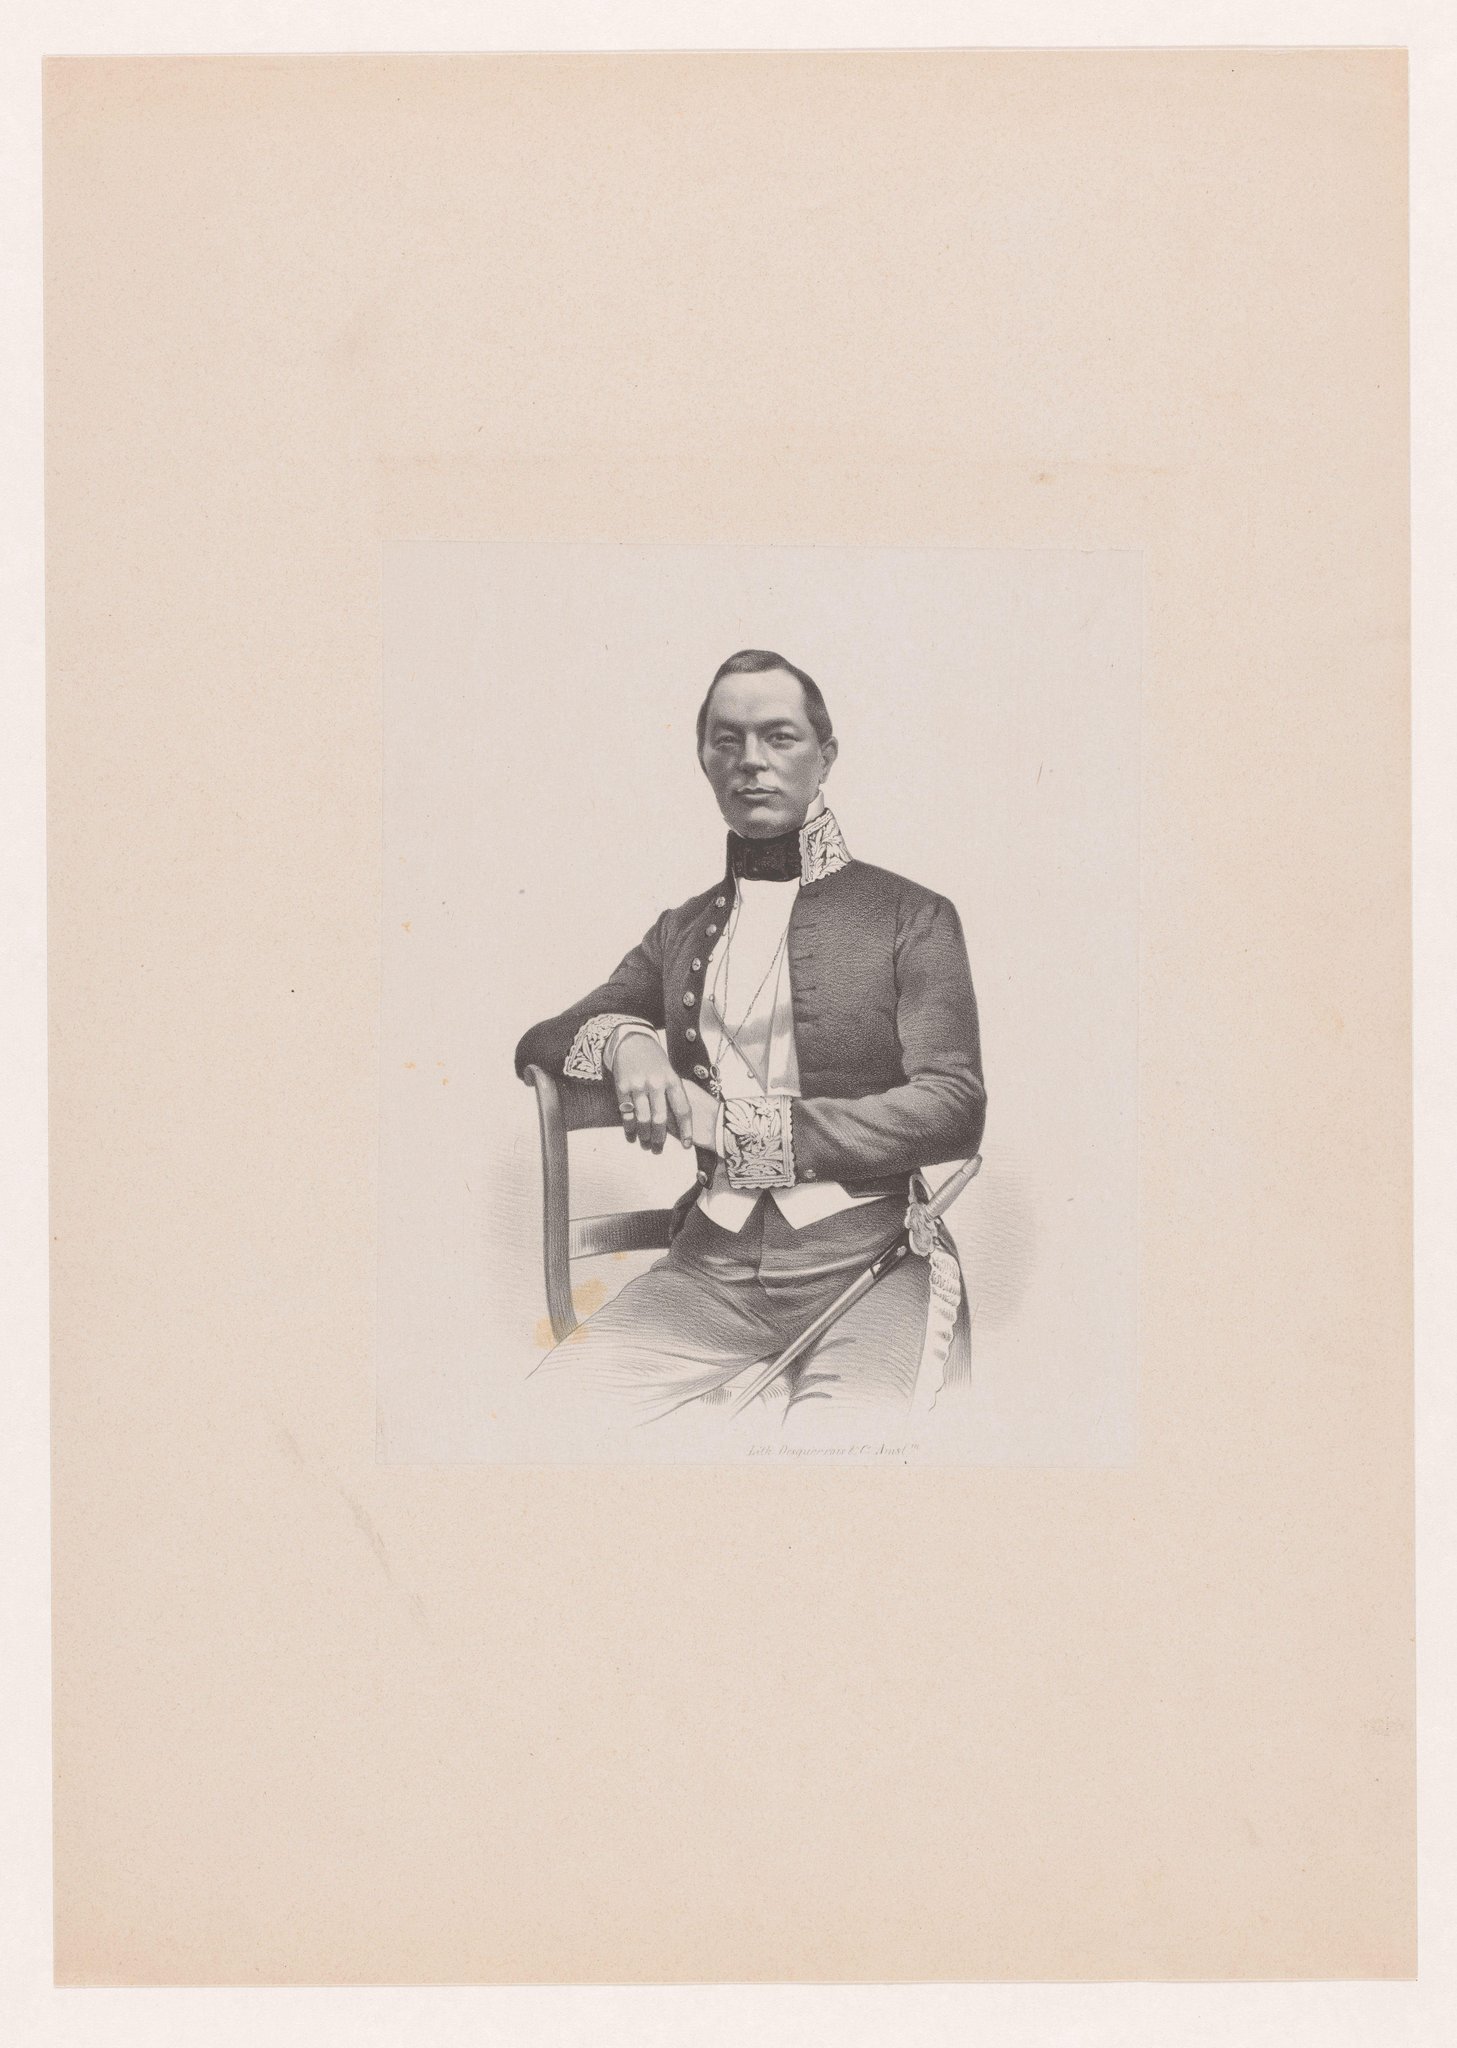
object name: print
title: Portret van een onbekende Indische officier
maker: Anonymous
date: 1827-1904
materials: paper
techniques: lithograph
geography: amsterdam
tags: historical persons (+ half-length portrait), dutch east indies, the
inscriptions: collector's mark: Lugt 2228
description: De geportretteerde, mogelijk een Indonesisch vorst, zit zijlings op een stoel en steunt met zijn rechter elleboog op de rugleuning. Hij is blootshoofds en draagt een sabel aan zijn heup.